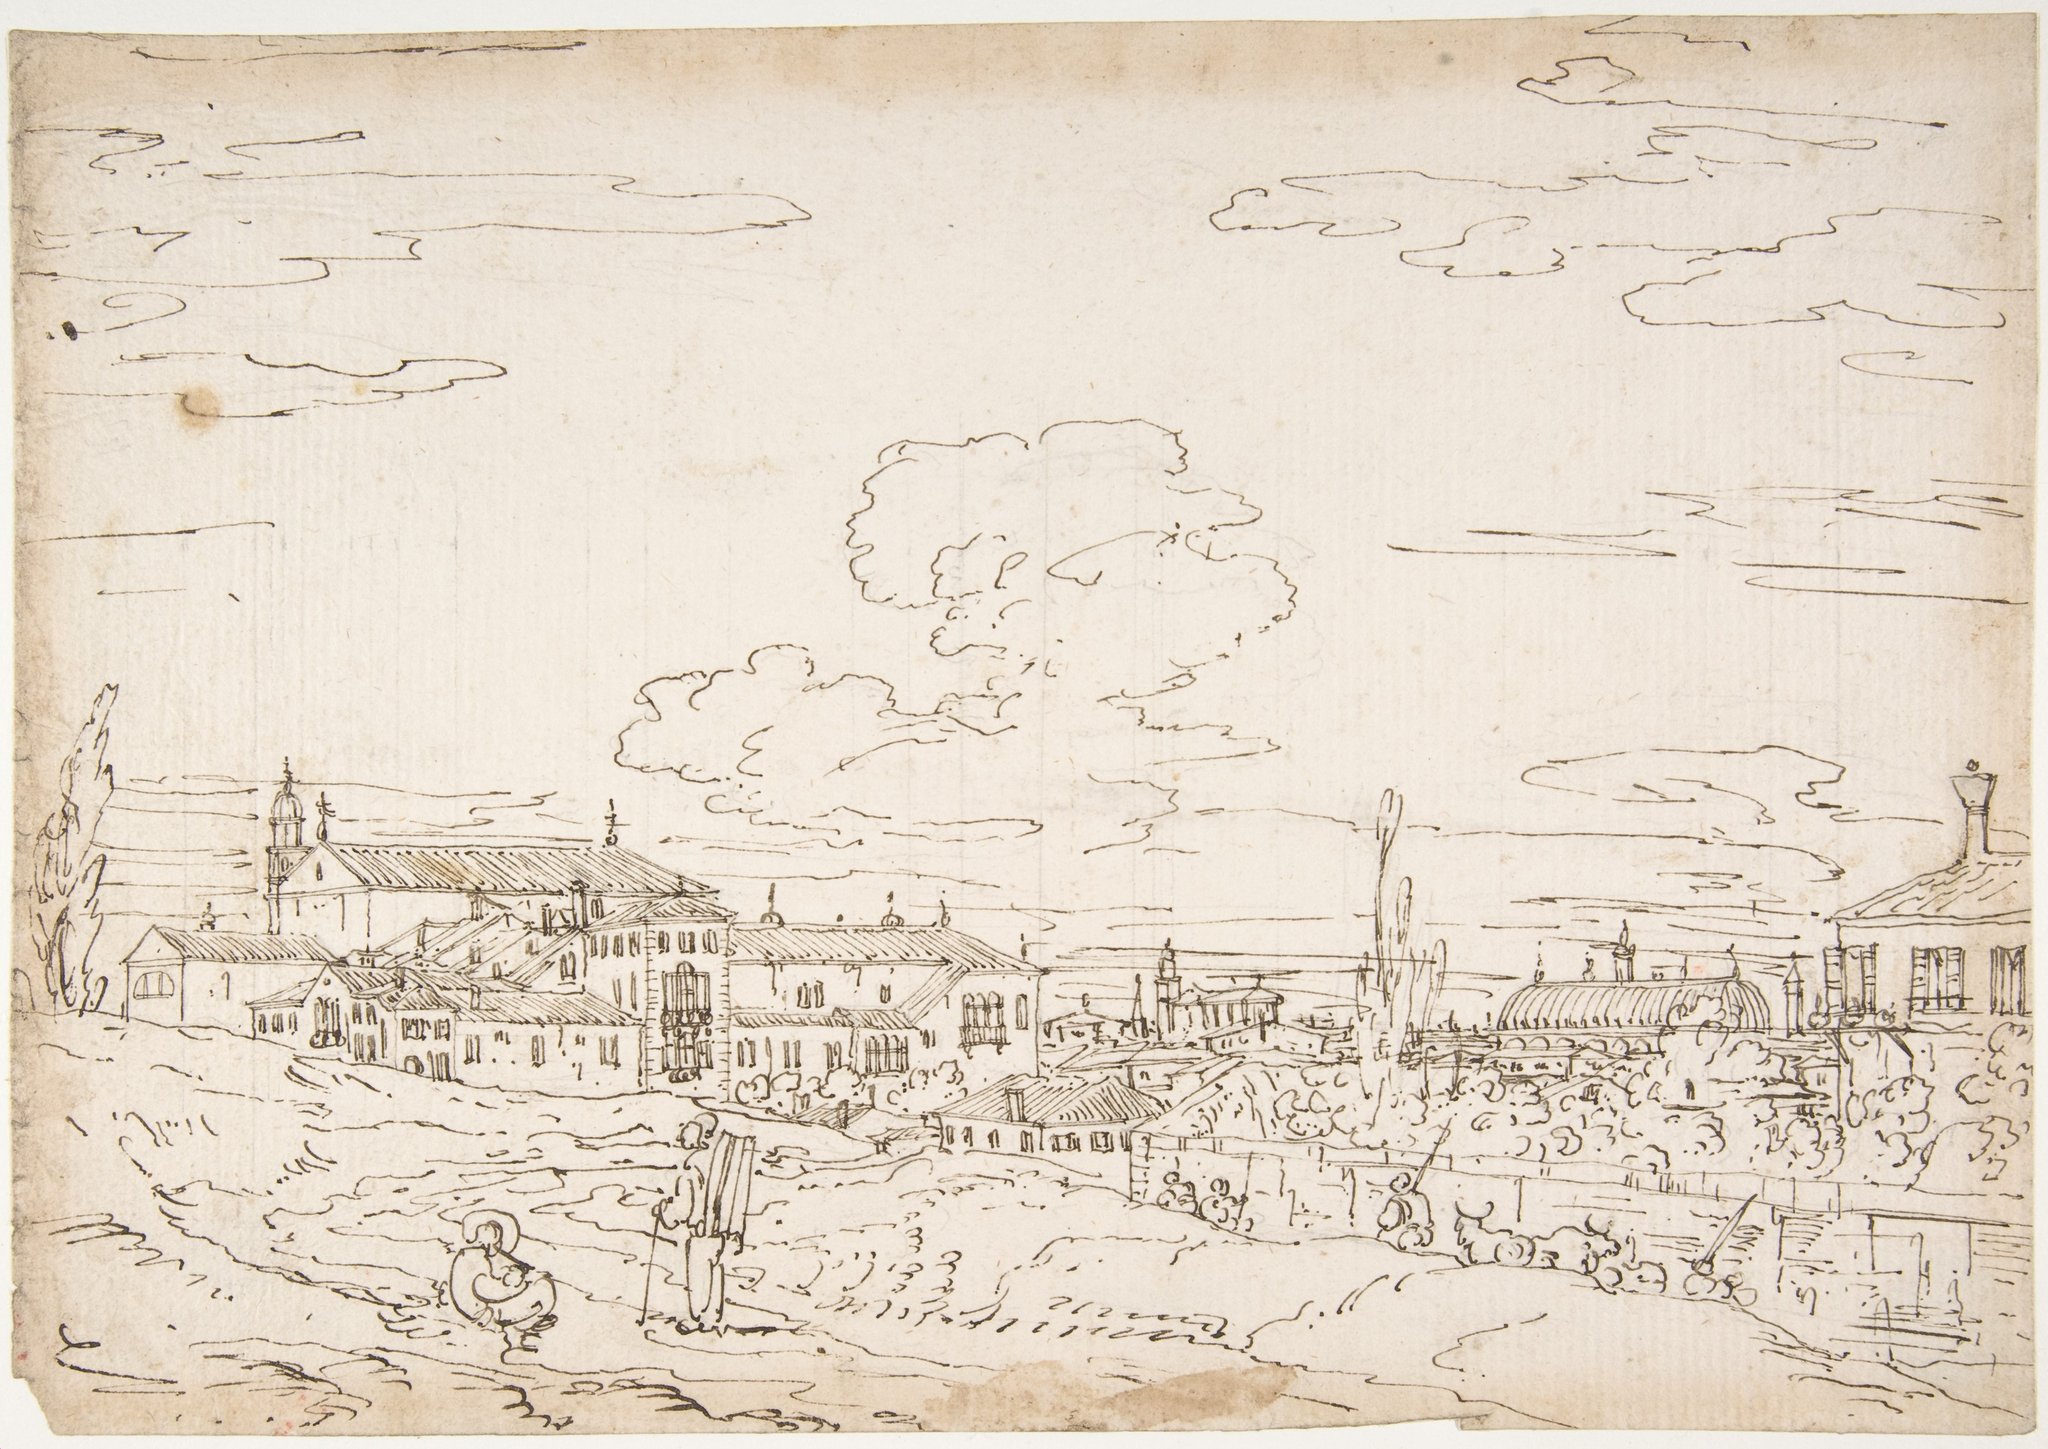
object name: drawing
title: Padua from the East, with San Francesco and the Salone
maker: bernardo bellotto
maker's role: artist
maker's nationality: italian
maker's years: 1722-1780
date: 1721-1780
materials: graphite, ink, lead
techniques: drawing, pen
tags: human figures,animals,buildings,landscapes